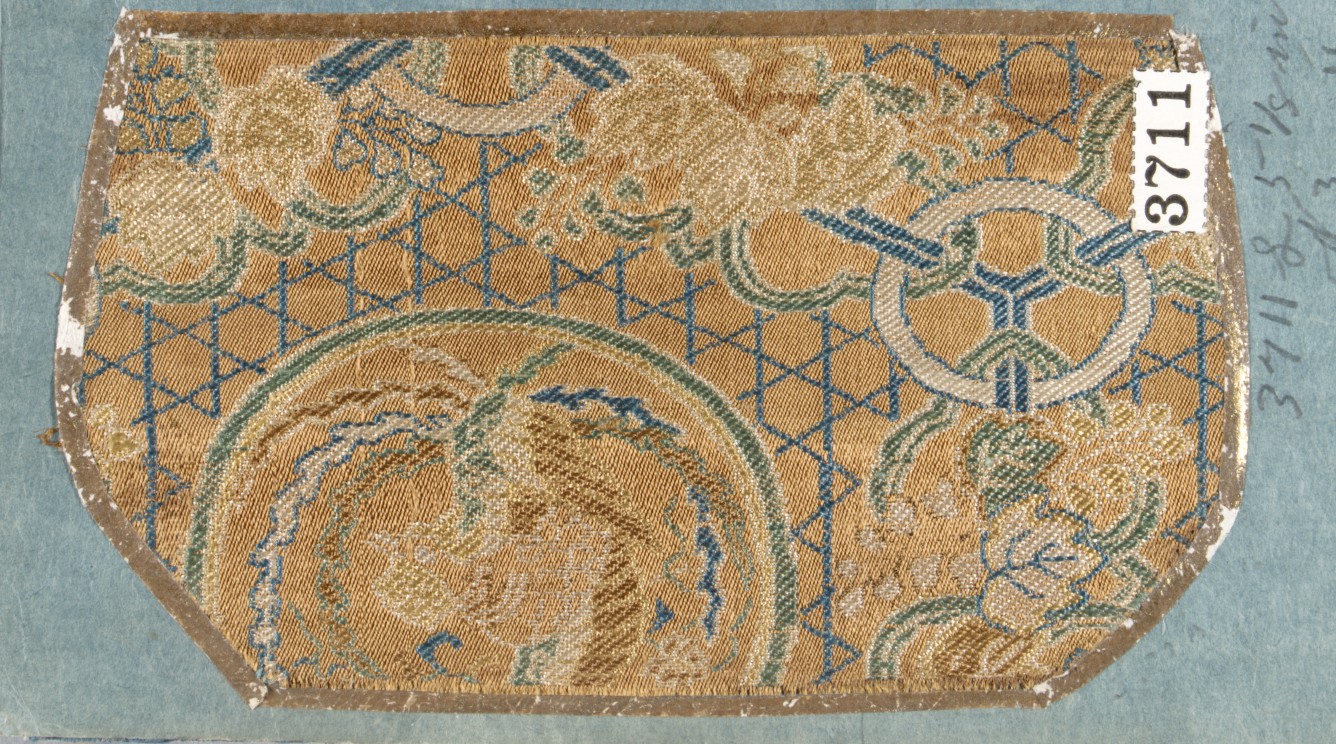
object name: sample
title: Textile Sample from Sample Book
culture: japanese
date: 1801-1900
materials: silk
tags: flowers